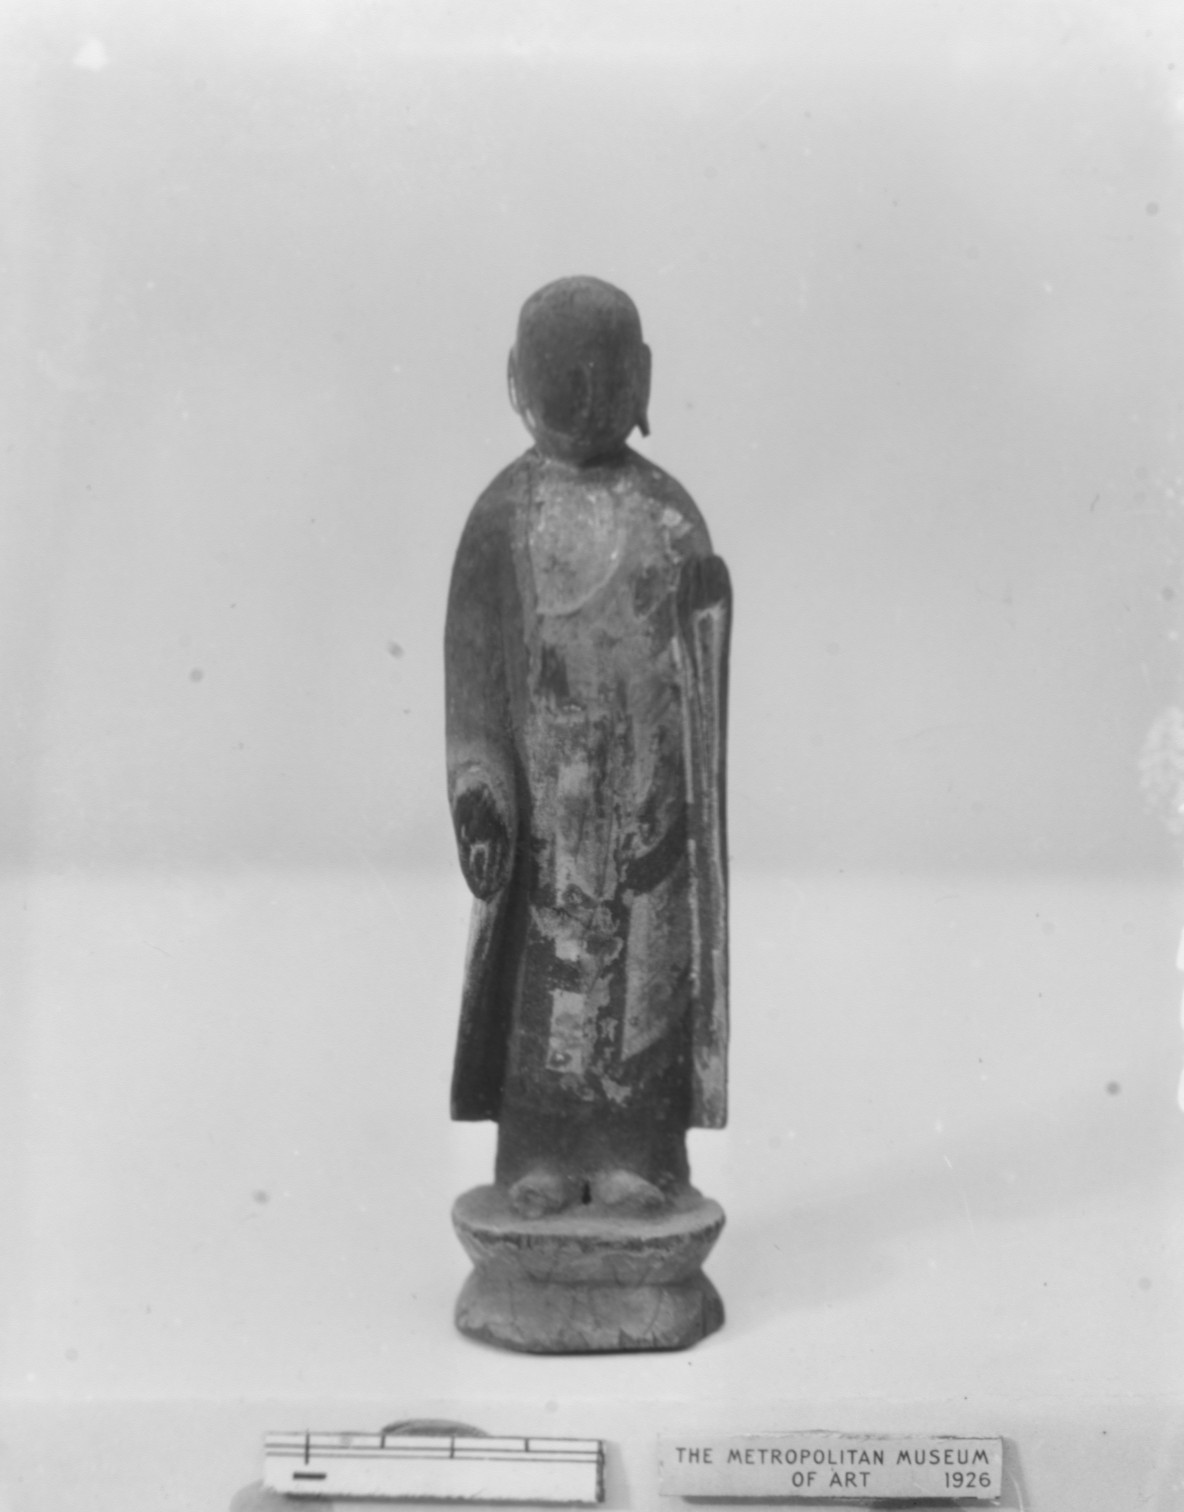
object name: statuette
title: Jizō Bosatsu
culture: japanese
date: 1201-1300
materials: wood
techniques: painting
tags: buddhism,bodhisattvas